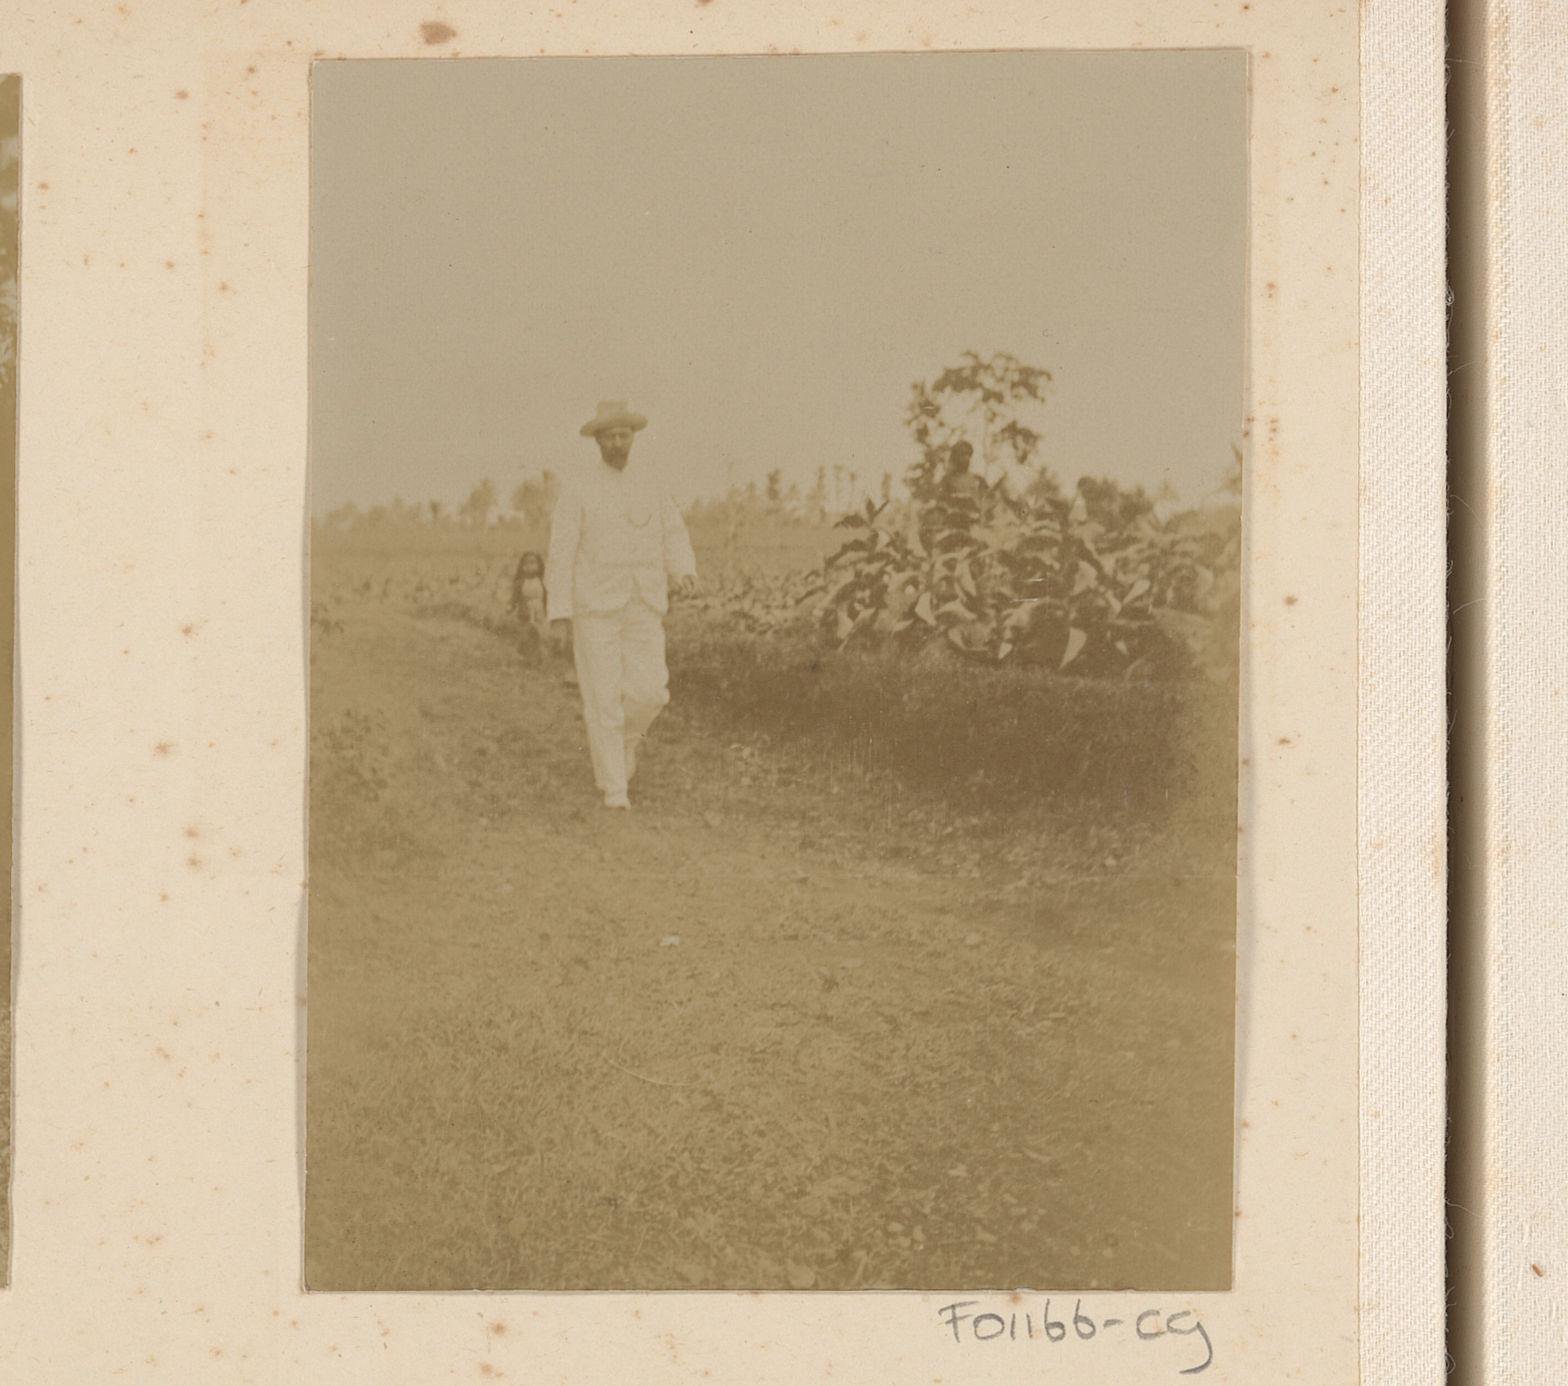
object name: photograph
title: Wandelende man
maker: Anonymous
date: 1880-1910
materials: photographic support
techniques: gelatin silver print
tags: adult man, historical persons, walking, dutch east indies, the